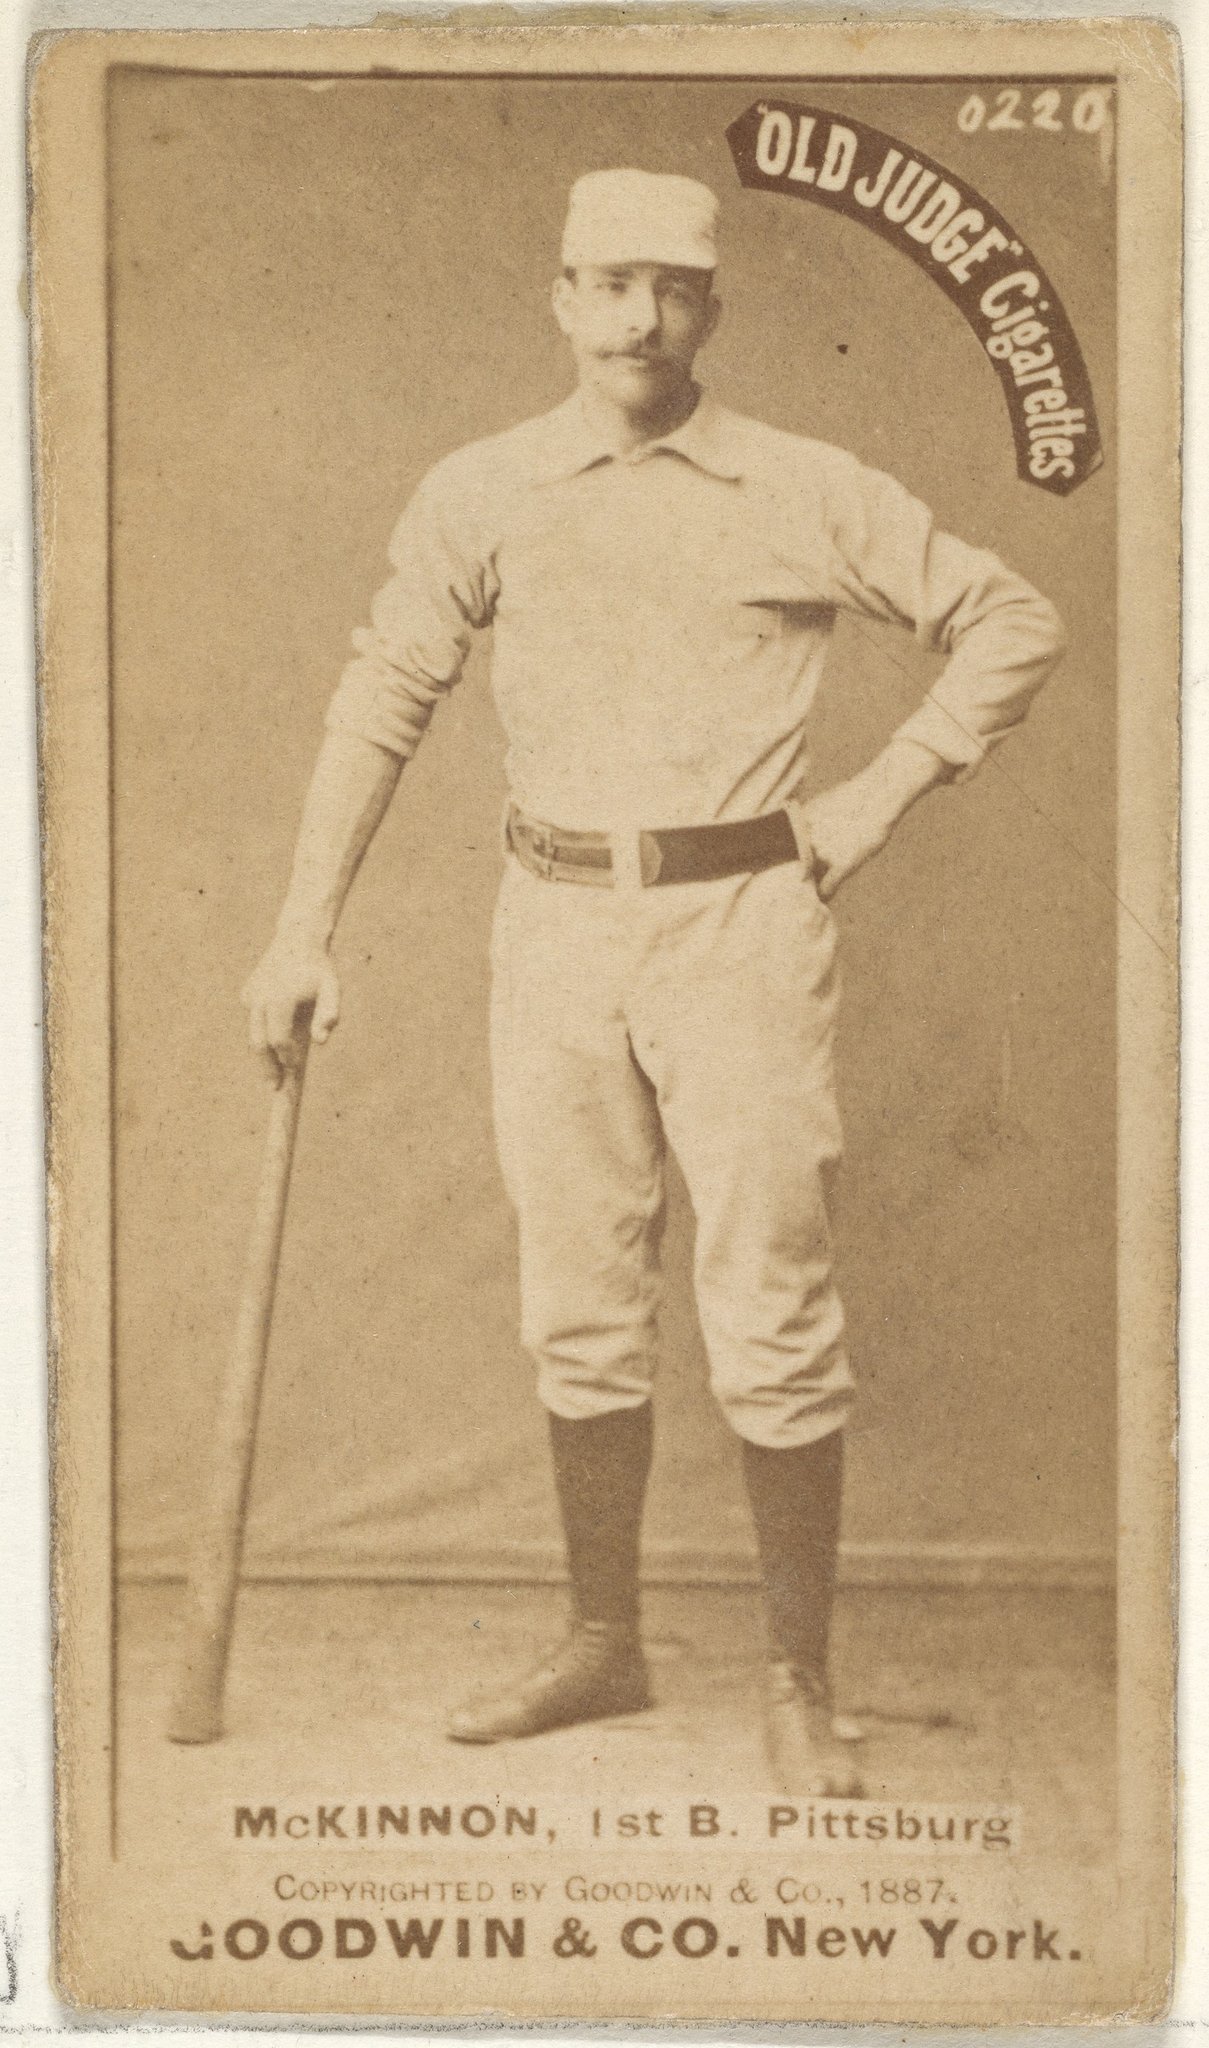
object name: baseball card, photograph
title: Alex McKinnon, 1st Base, Pittsburgh, from the Old Judge series (N172) for Old Judge Cigarettes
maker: goodwin & company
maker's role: publisher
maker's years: 1850-1950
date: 1887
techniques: albumen silver print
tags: men,portraits,baseball,athletes